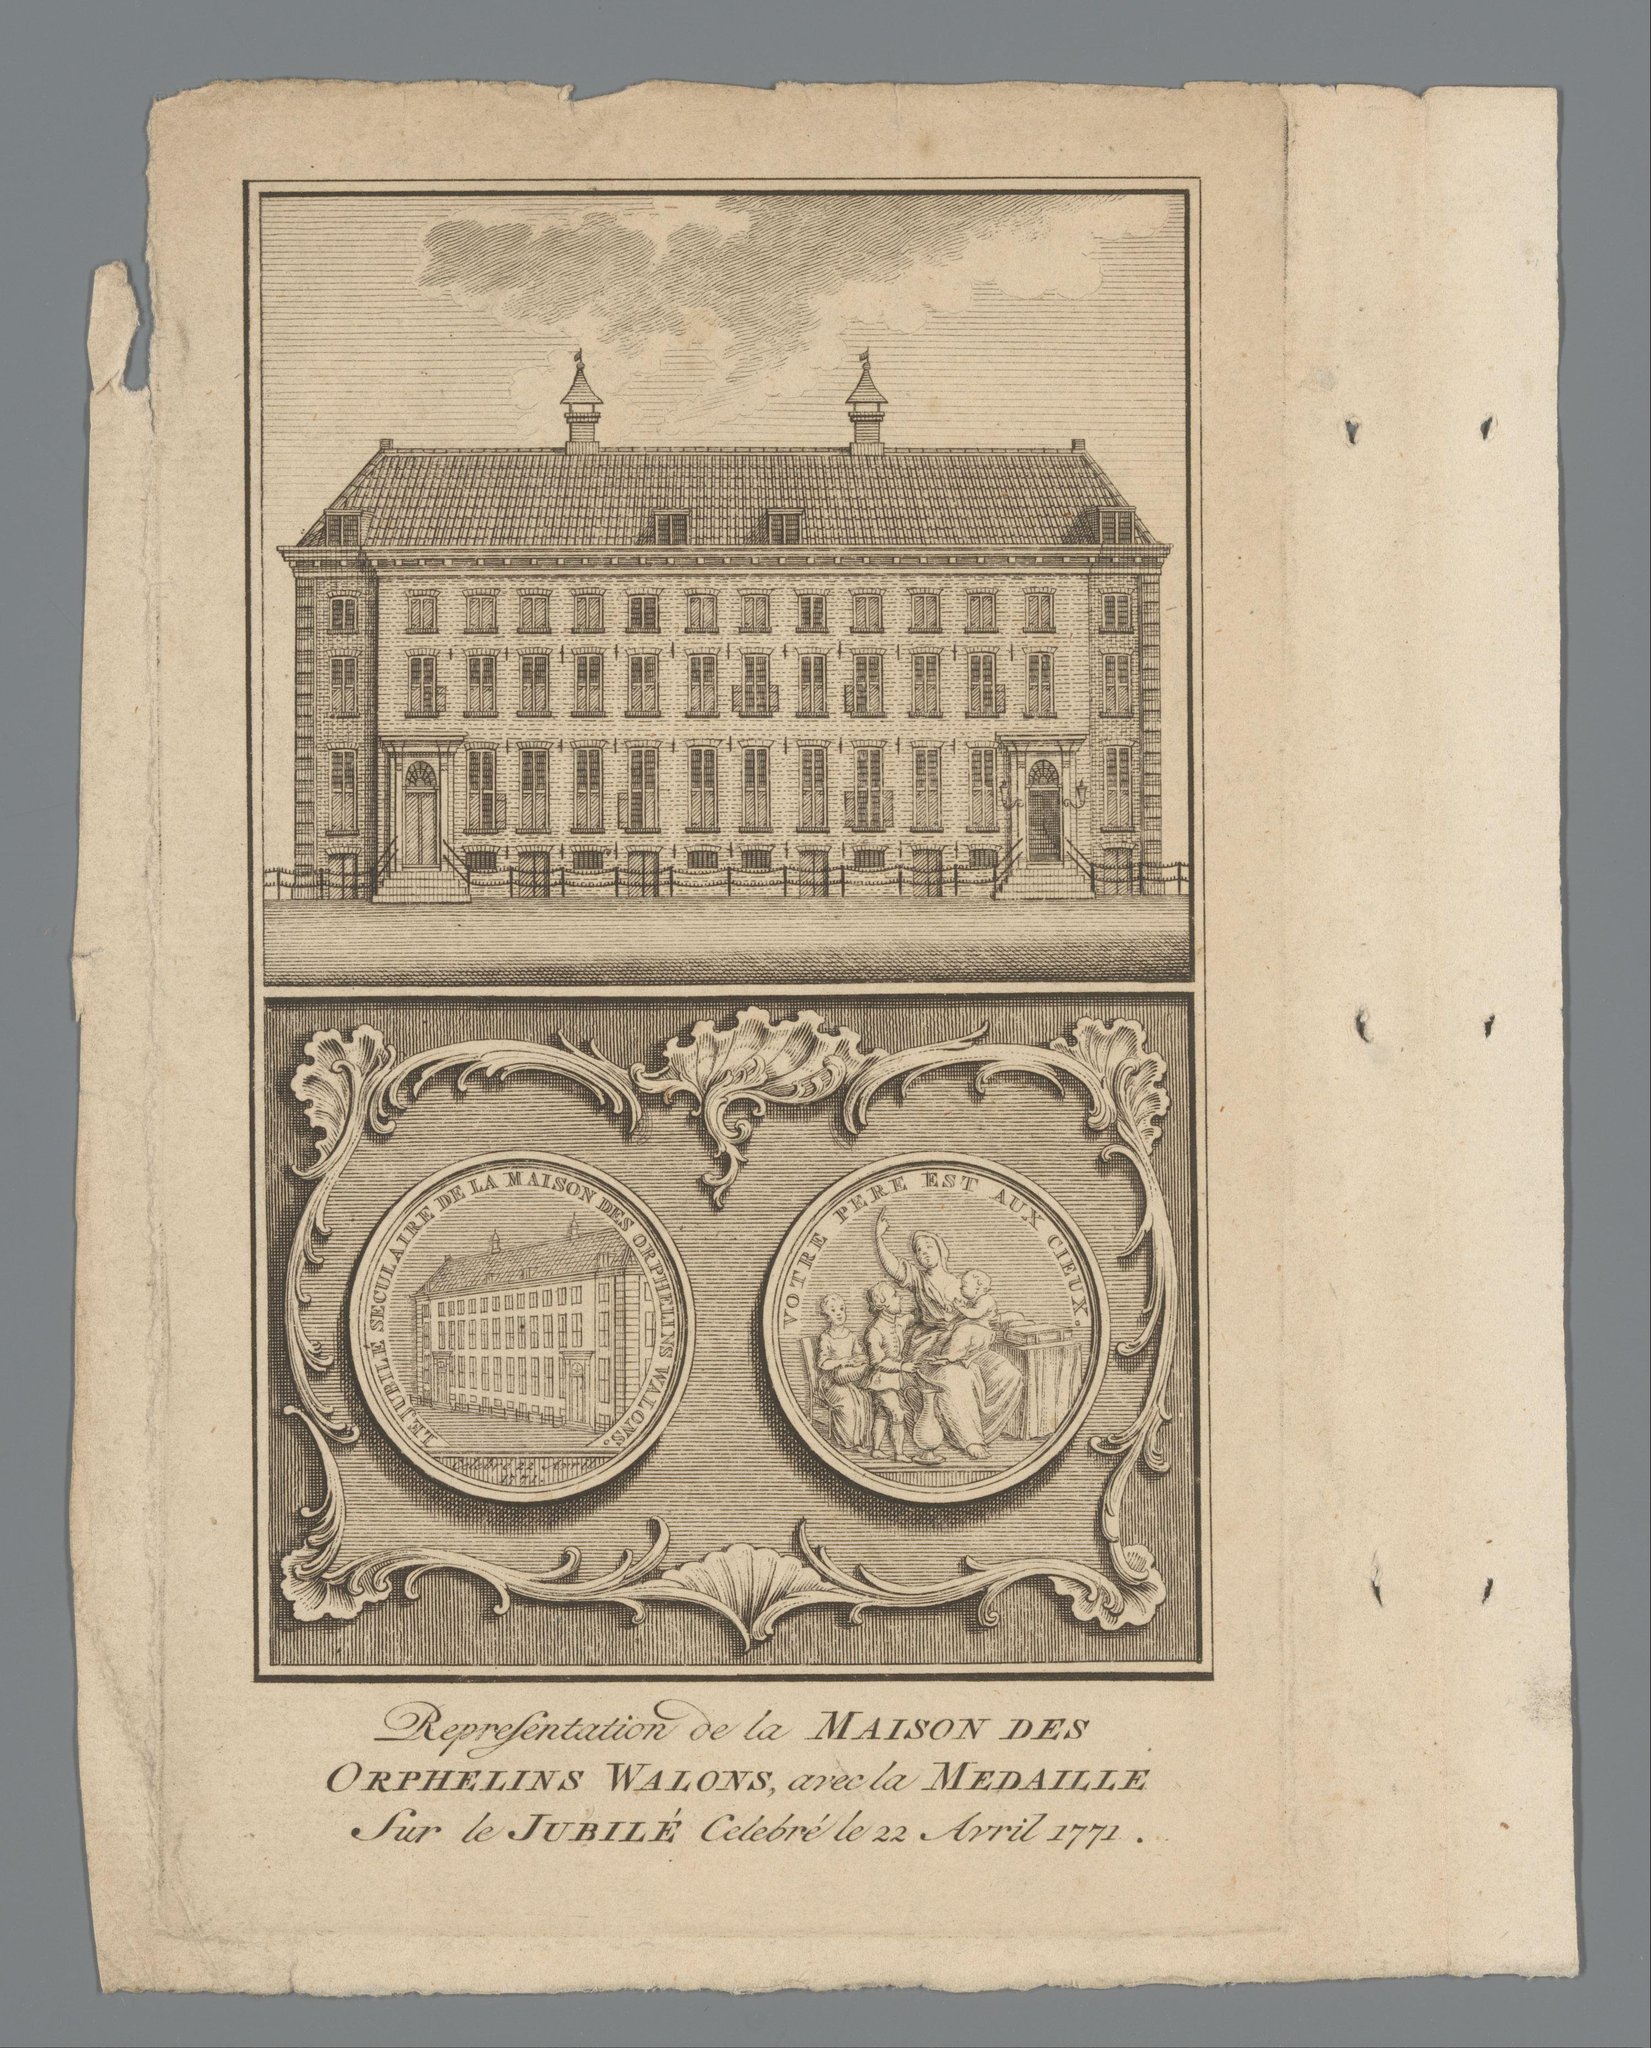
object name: print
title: Representation de la Maison des Orphelins Walons, avec la Medaille Sur le Jubilé Celebré le 22 Avril 1771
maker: Anonymous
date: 1771-1773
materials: paper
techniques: engraving, etching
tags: memorial medal, orphanage